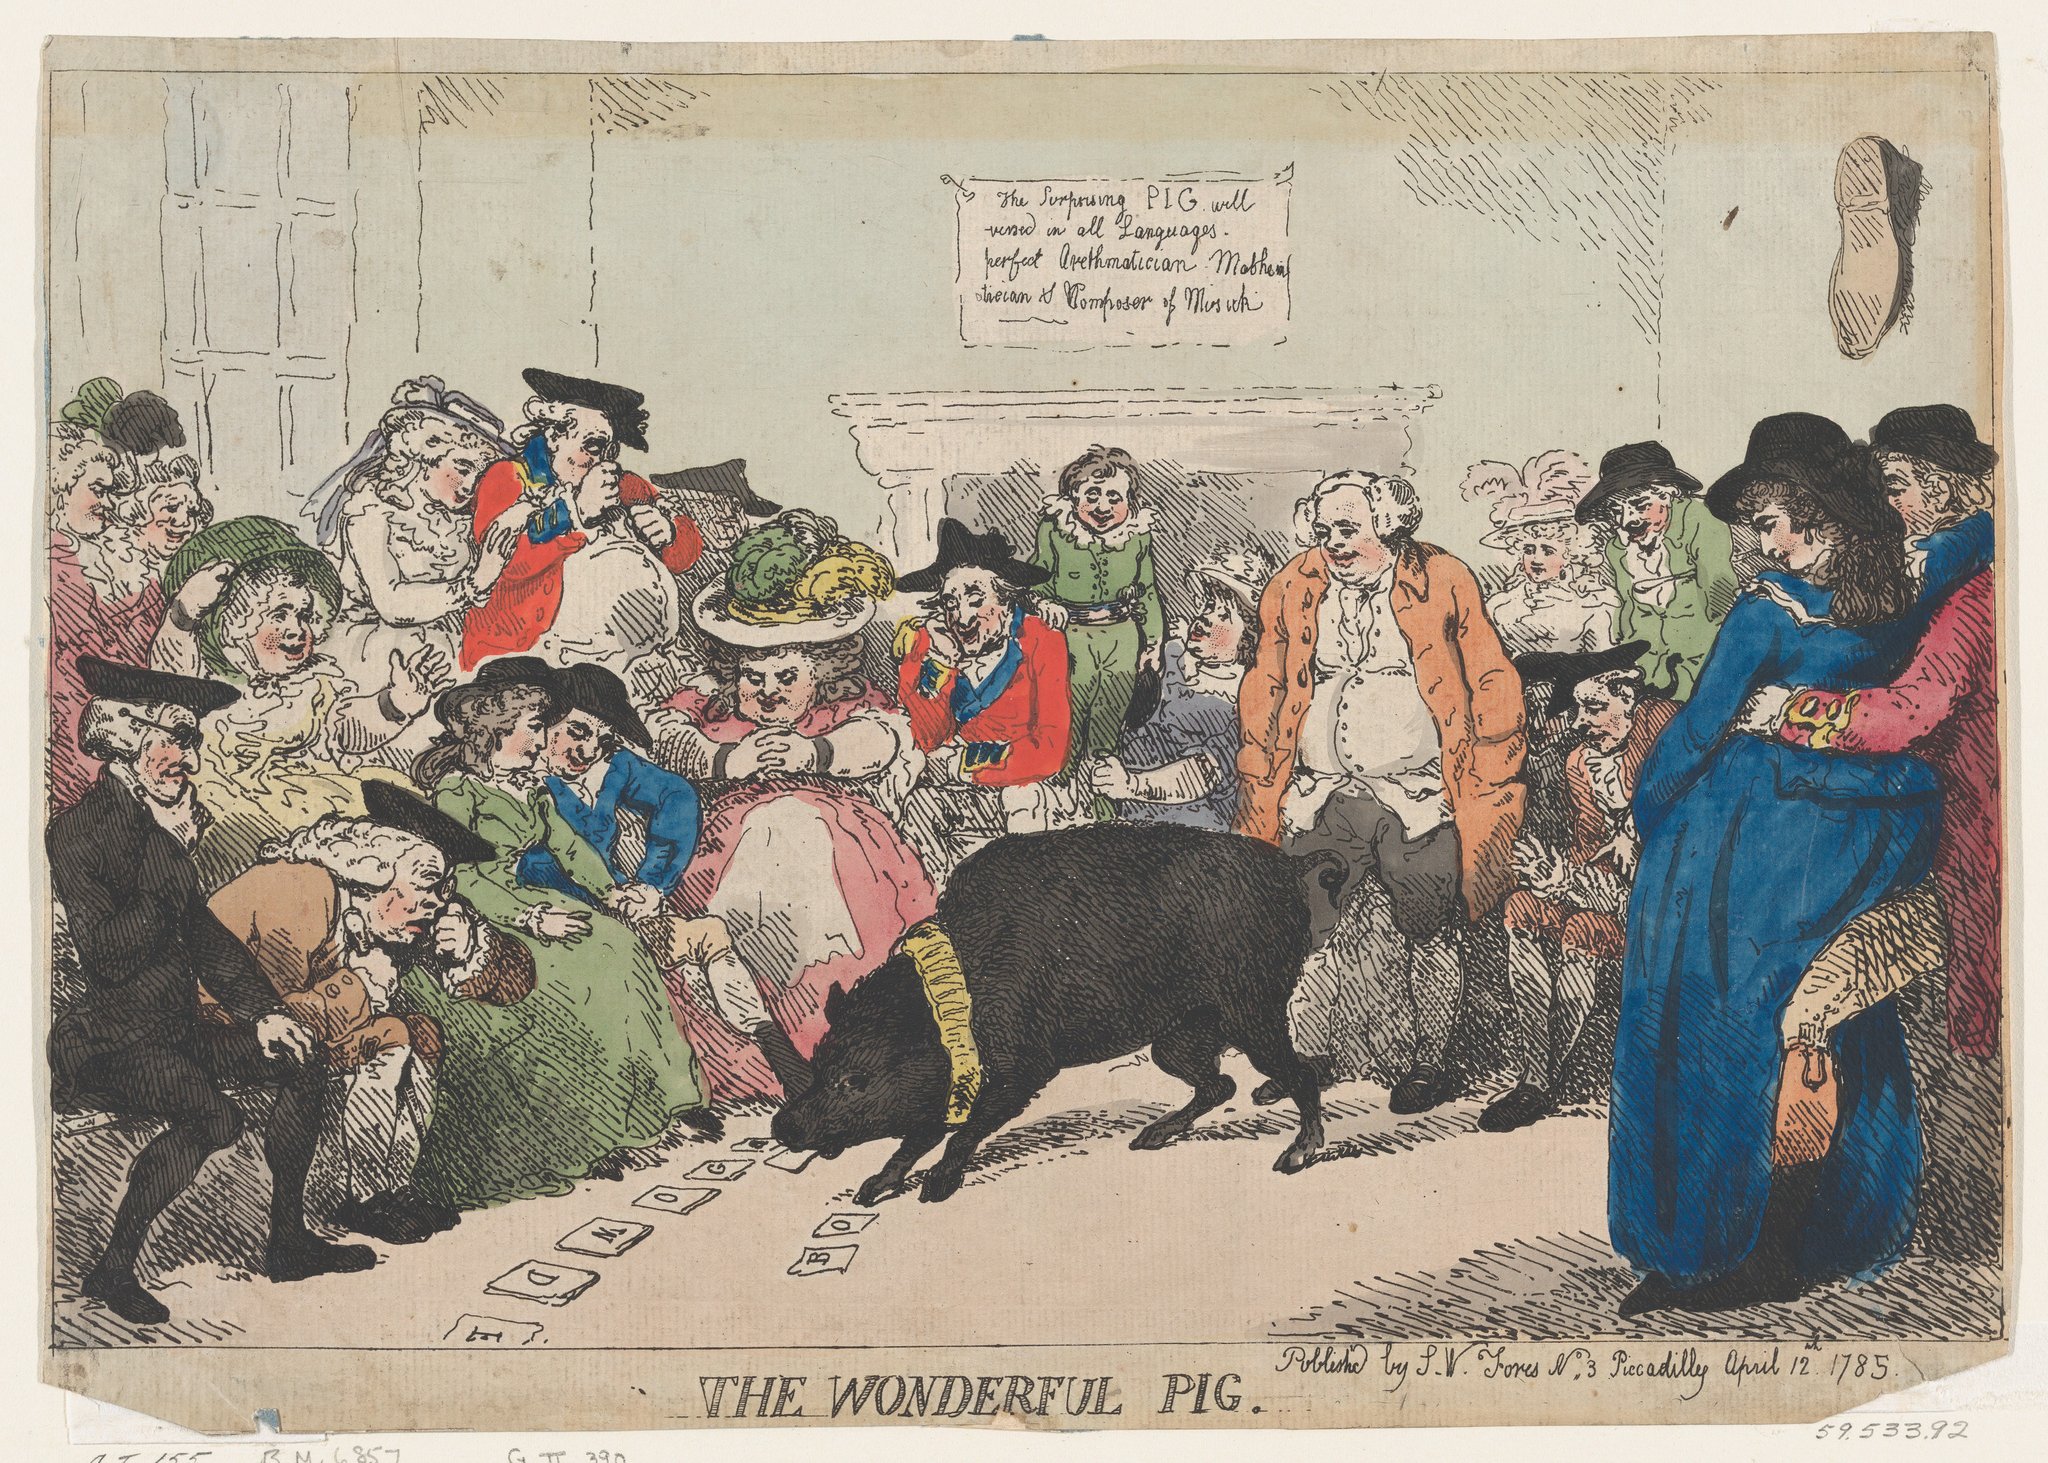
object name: print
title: The Wonderful Pig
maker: thomas rowlandson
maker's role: artist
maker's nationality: british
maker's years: 1757-1827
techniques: etching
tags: pigs,crowd